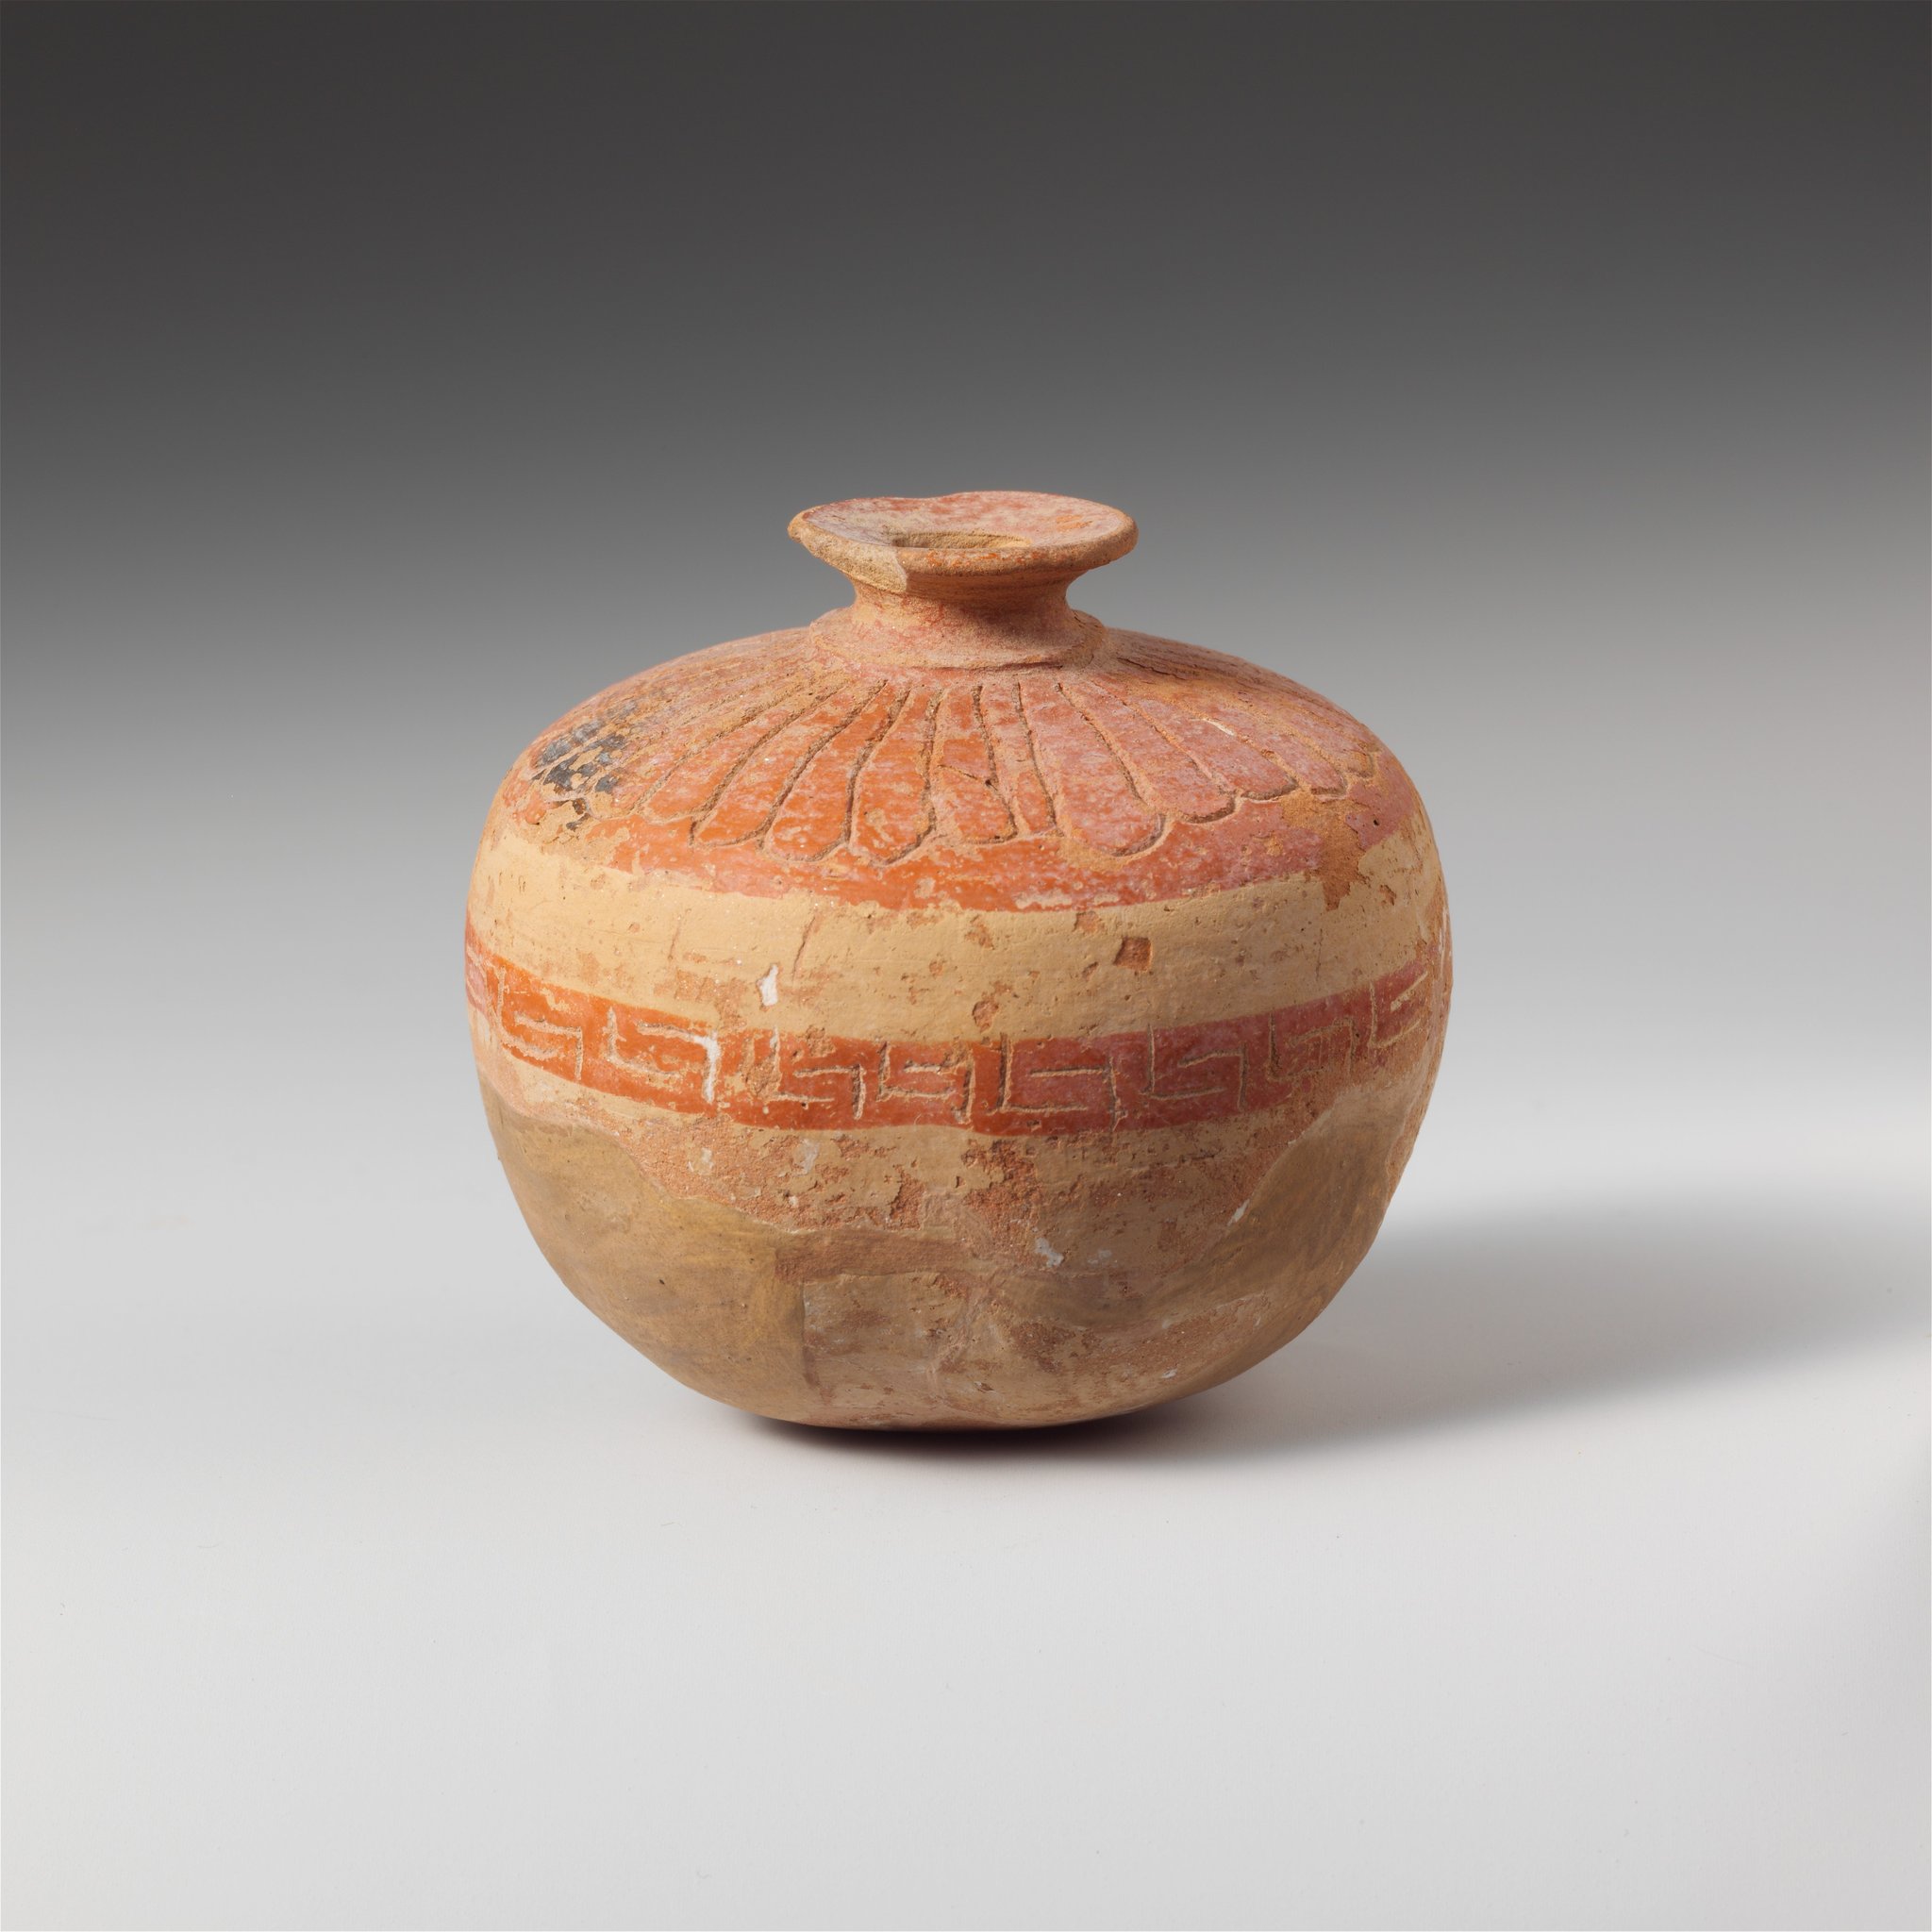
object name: aryballos in the form of a pomegranate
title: Terracotta aryballos (oil flask) in the form of a pomegranate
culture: lydian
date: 600-501 BCE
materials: terracotta